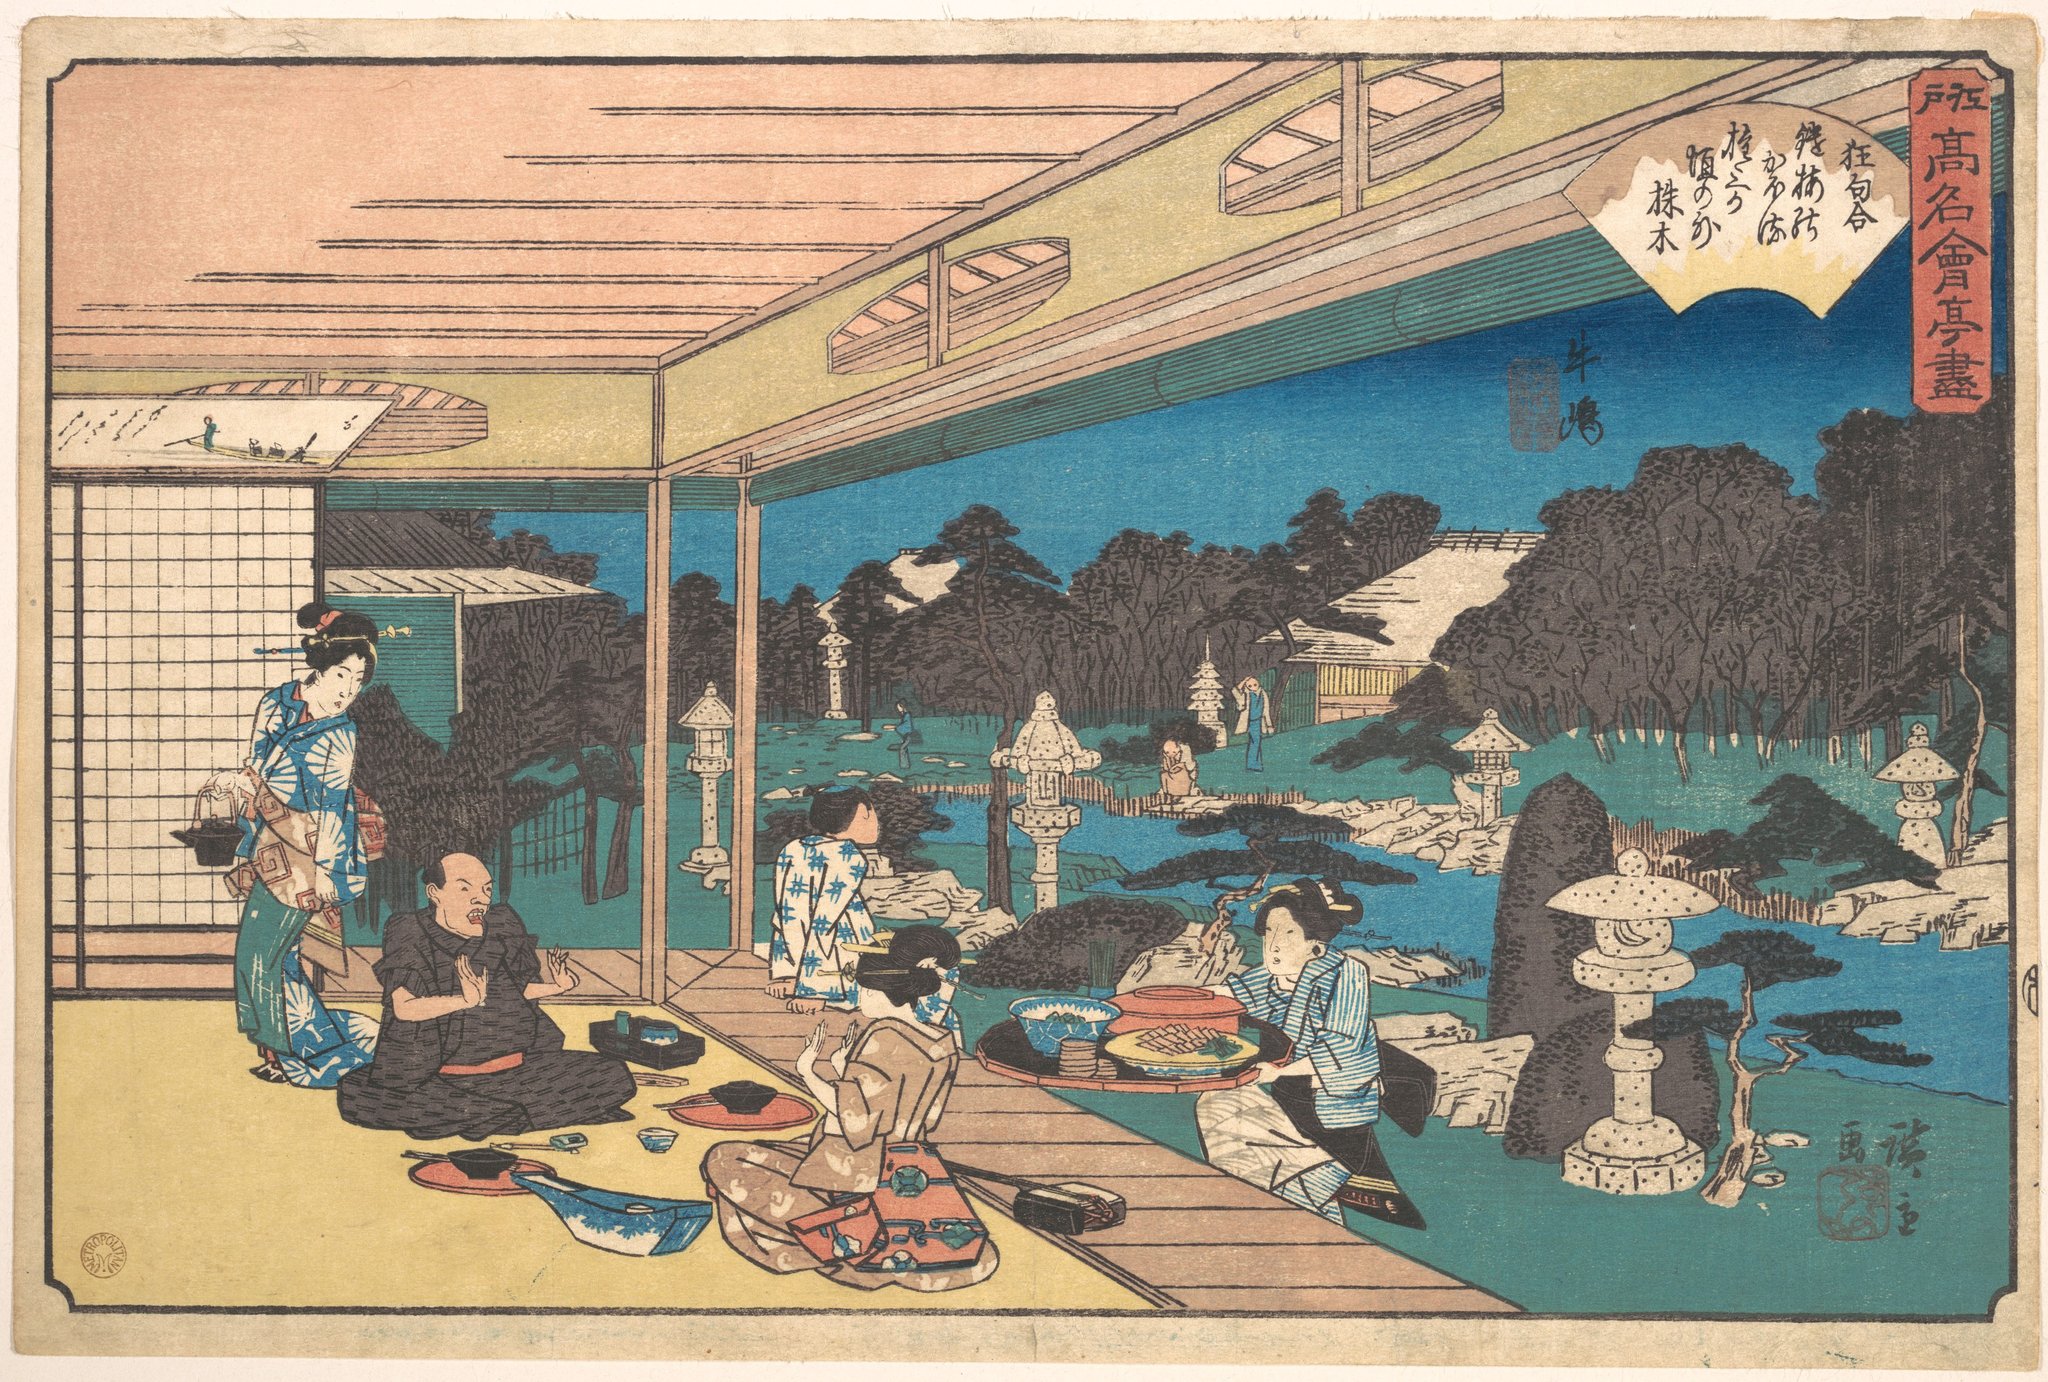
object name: print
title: Ushijima (Musashi-ya)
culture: japanese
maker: utagawa hiroshige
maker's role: artist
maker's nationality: japanese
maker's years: 1797-1858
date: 1840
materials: ink, paper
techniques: woodblock print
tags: men,women,trees